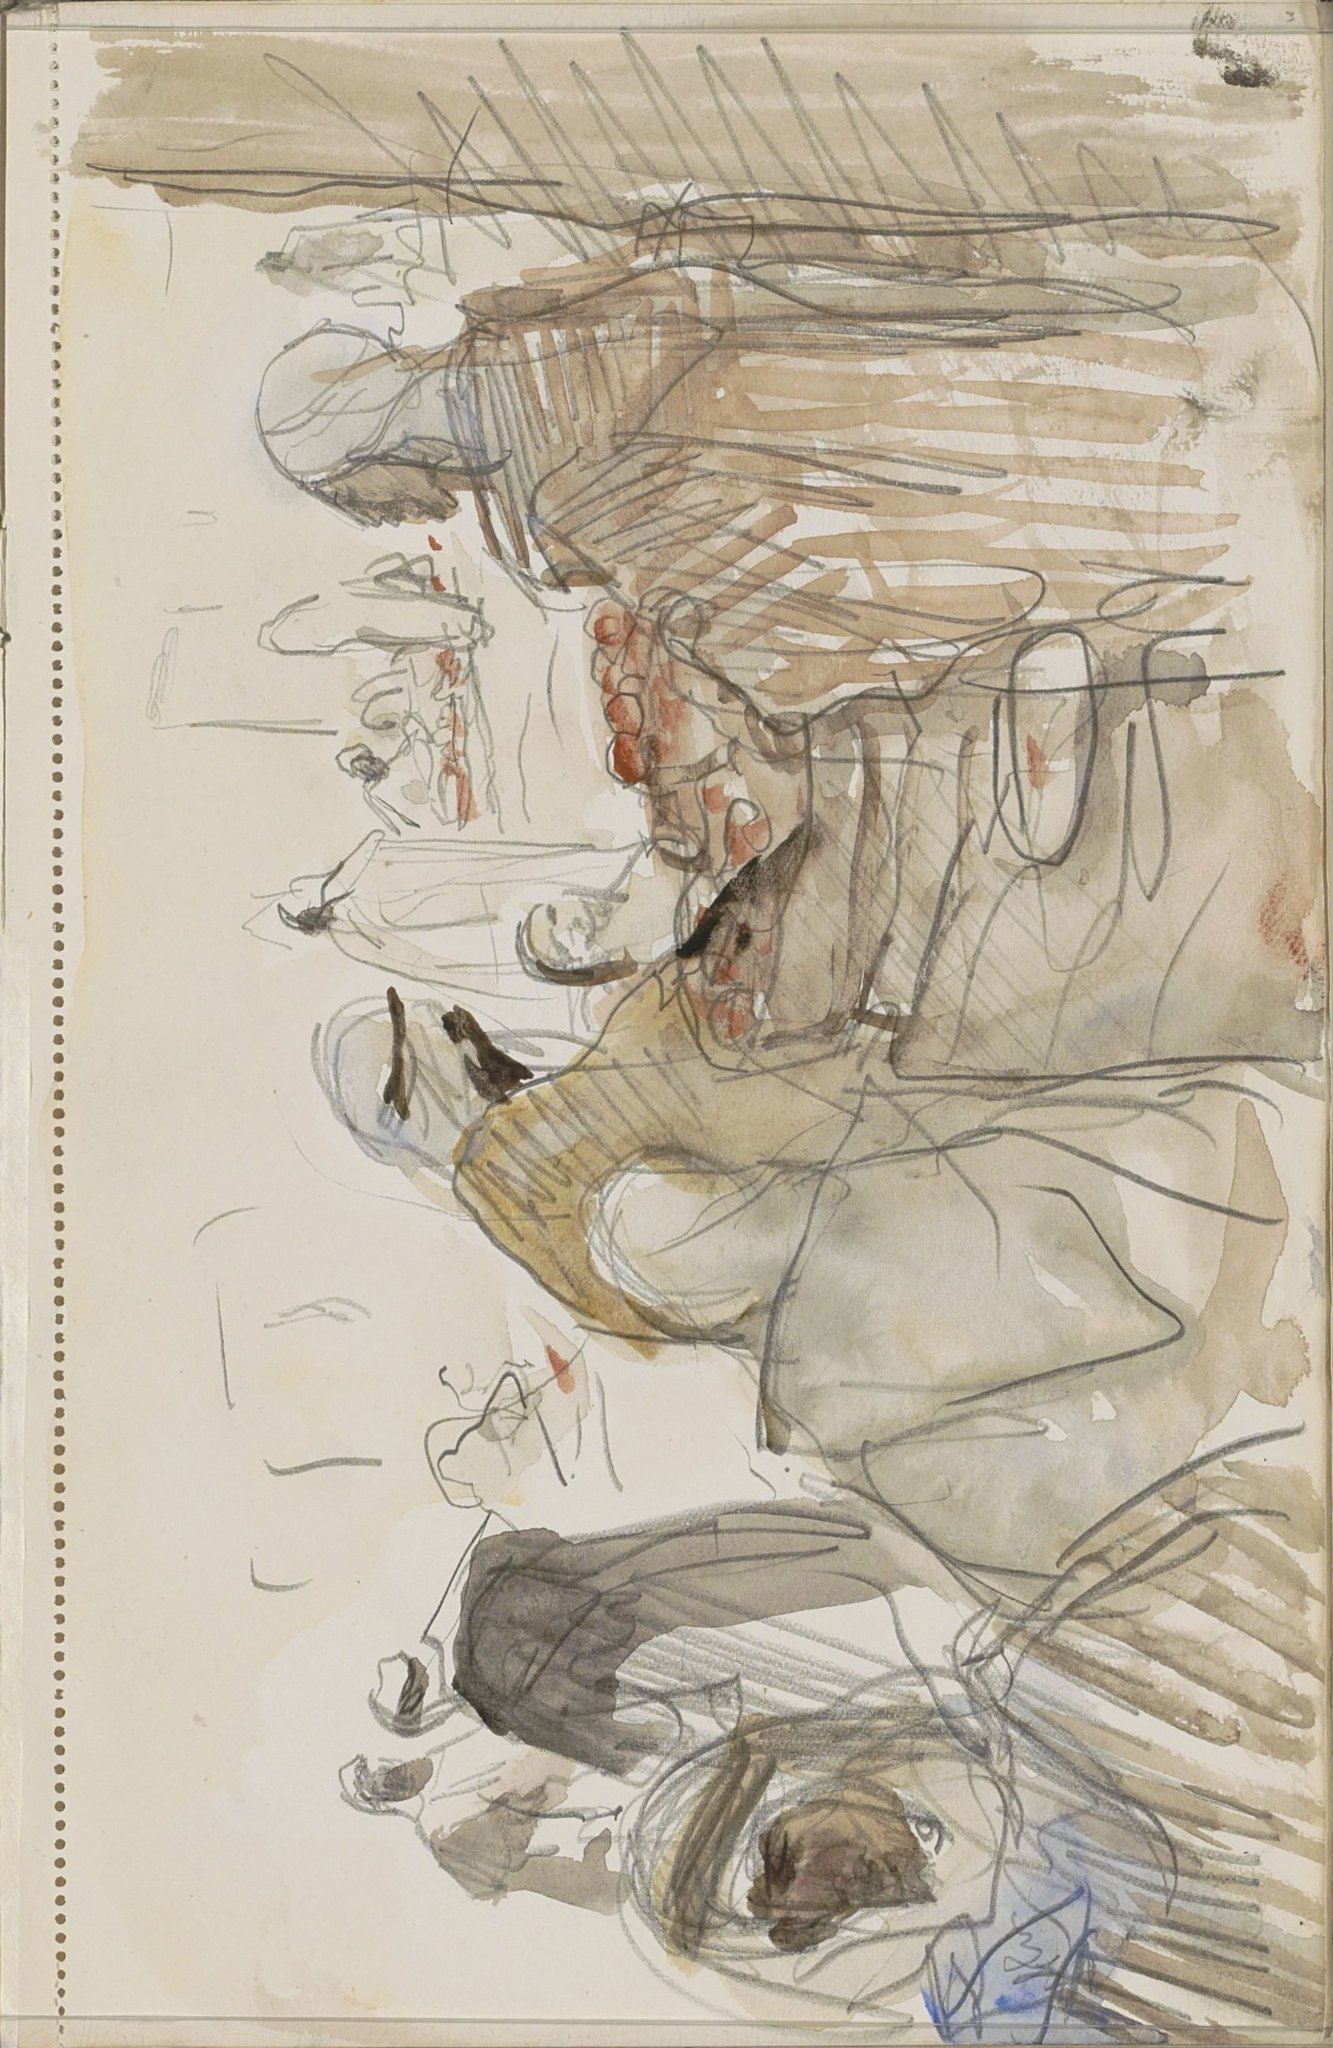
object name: sketchbook leaf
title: Marktscène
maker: marius bauer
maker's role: draughtsman, print maker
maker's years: 1867-1932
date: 1923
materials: paper, pencil, watercolor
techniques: brush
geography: morocco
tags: africans, market, street (+ city(-scape) with figures, staffage)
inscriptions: kleurnotitie, handgeschreven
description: Pagina 3 uit een schetsboek met 66 bladen.